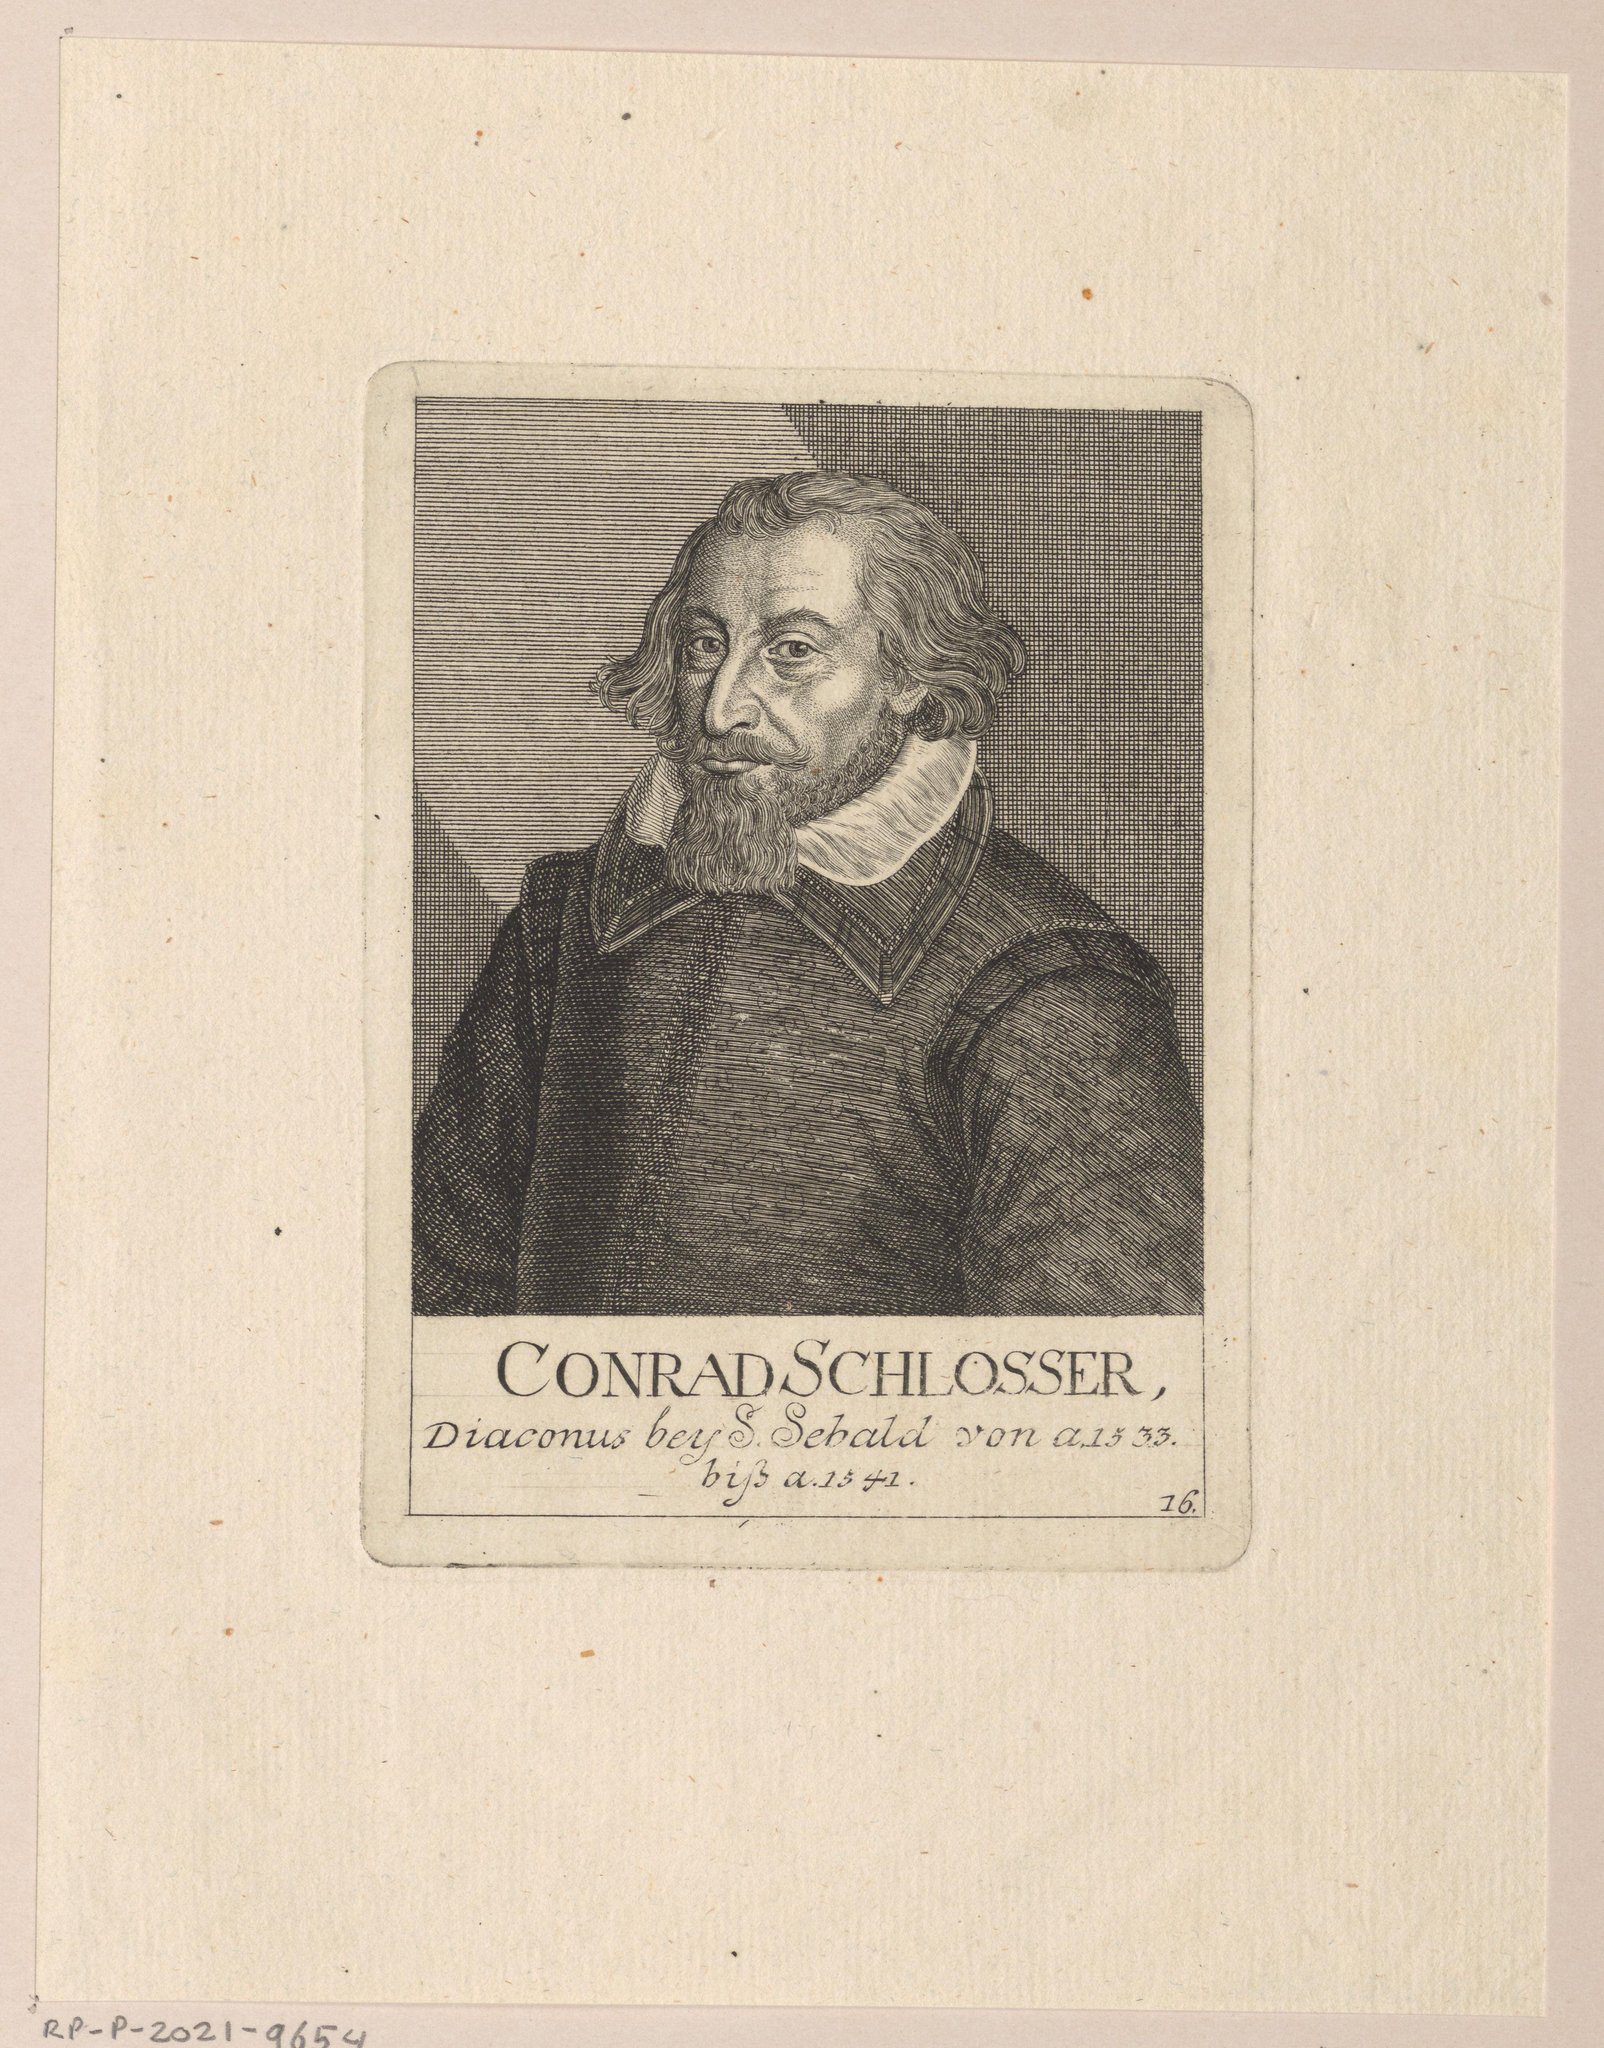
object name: print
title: Portret van Conrad Schlosser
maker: christoph melchior roth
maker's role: print maker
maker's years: 1720-1798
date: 1756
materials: paper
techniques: engraving, etching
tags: theologian, historical persons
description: Prent waarschijnlijk uit: Würfel, Andreas. Diptycha ecclesiae Sebaldianae (...). Neurenberg: Christoph Melchior Roth, 1756.